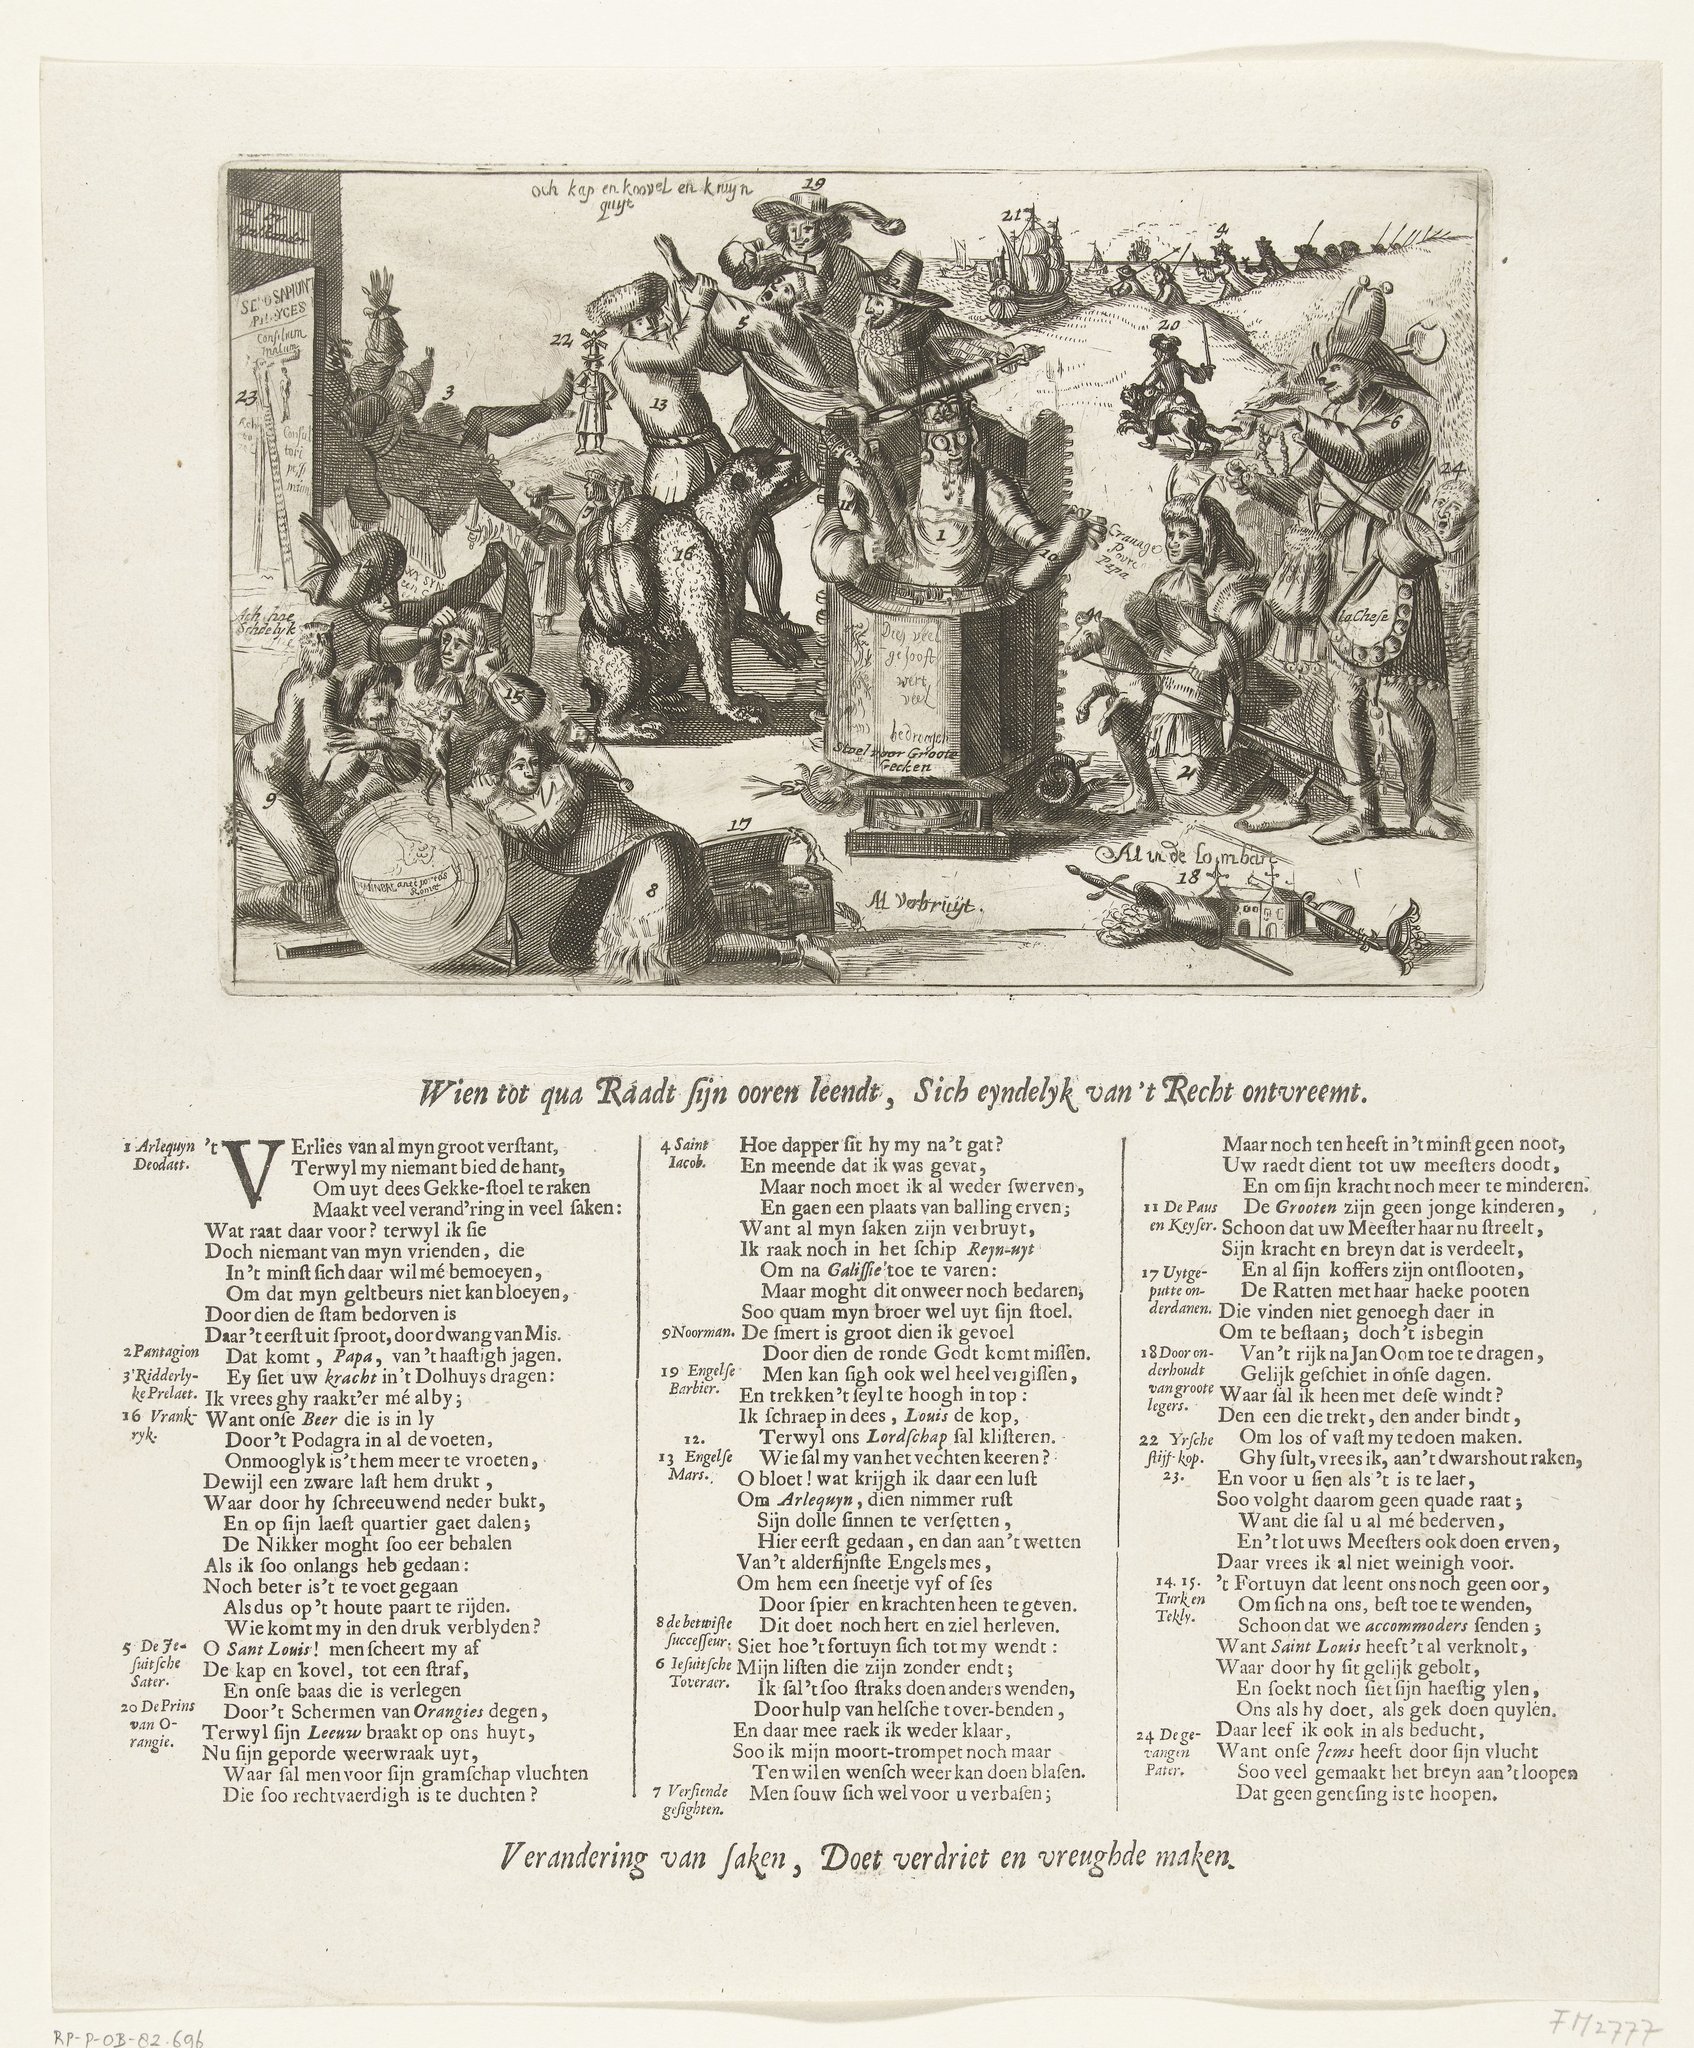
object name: cartoon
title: Wien tot qua Raadt sijn ooren leendt, Sich eyndelyk van 't Recht ontvreemt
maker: Anonymous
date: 1674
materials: paper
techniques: engraving, etching, letterpress printing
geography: northern netherlands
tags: jacobus ii (koning van engeland en schotland), the hague, william iii (prince of orange and king of england, scotland, and ireland), lodewijk xiv (koning van frankrijk), london, rome, political caricatures and satires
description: Spotprent op de Franse koning Lodewijk XIV, 1689. De koning in een kindergekkenstoel met poppen van de paus en de keizer en omringd door allerlei gekken en dwazen. Links van hem een beer met een pak op zijn rug. Linksvoor worden vorsten die treuren bij een wereldbol ontdekt door een Turk. Rechts de dauphin op een stokpaardje. Op de achtergrond vlucht koning Jacobus II voor Willem III op de Hollandse Leeuw, links het molenaarskind. Met een spotvers in 3 kolommen waarin de voorstelling wordt verklaard.